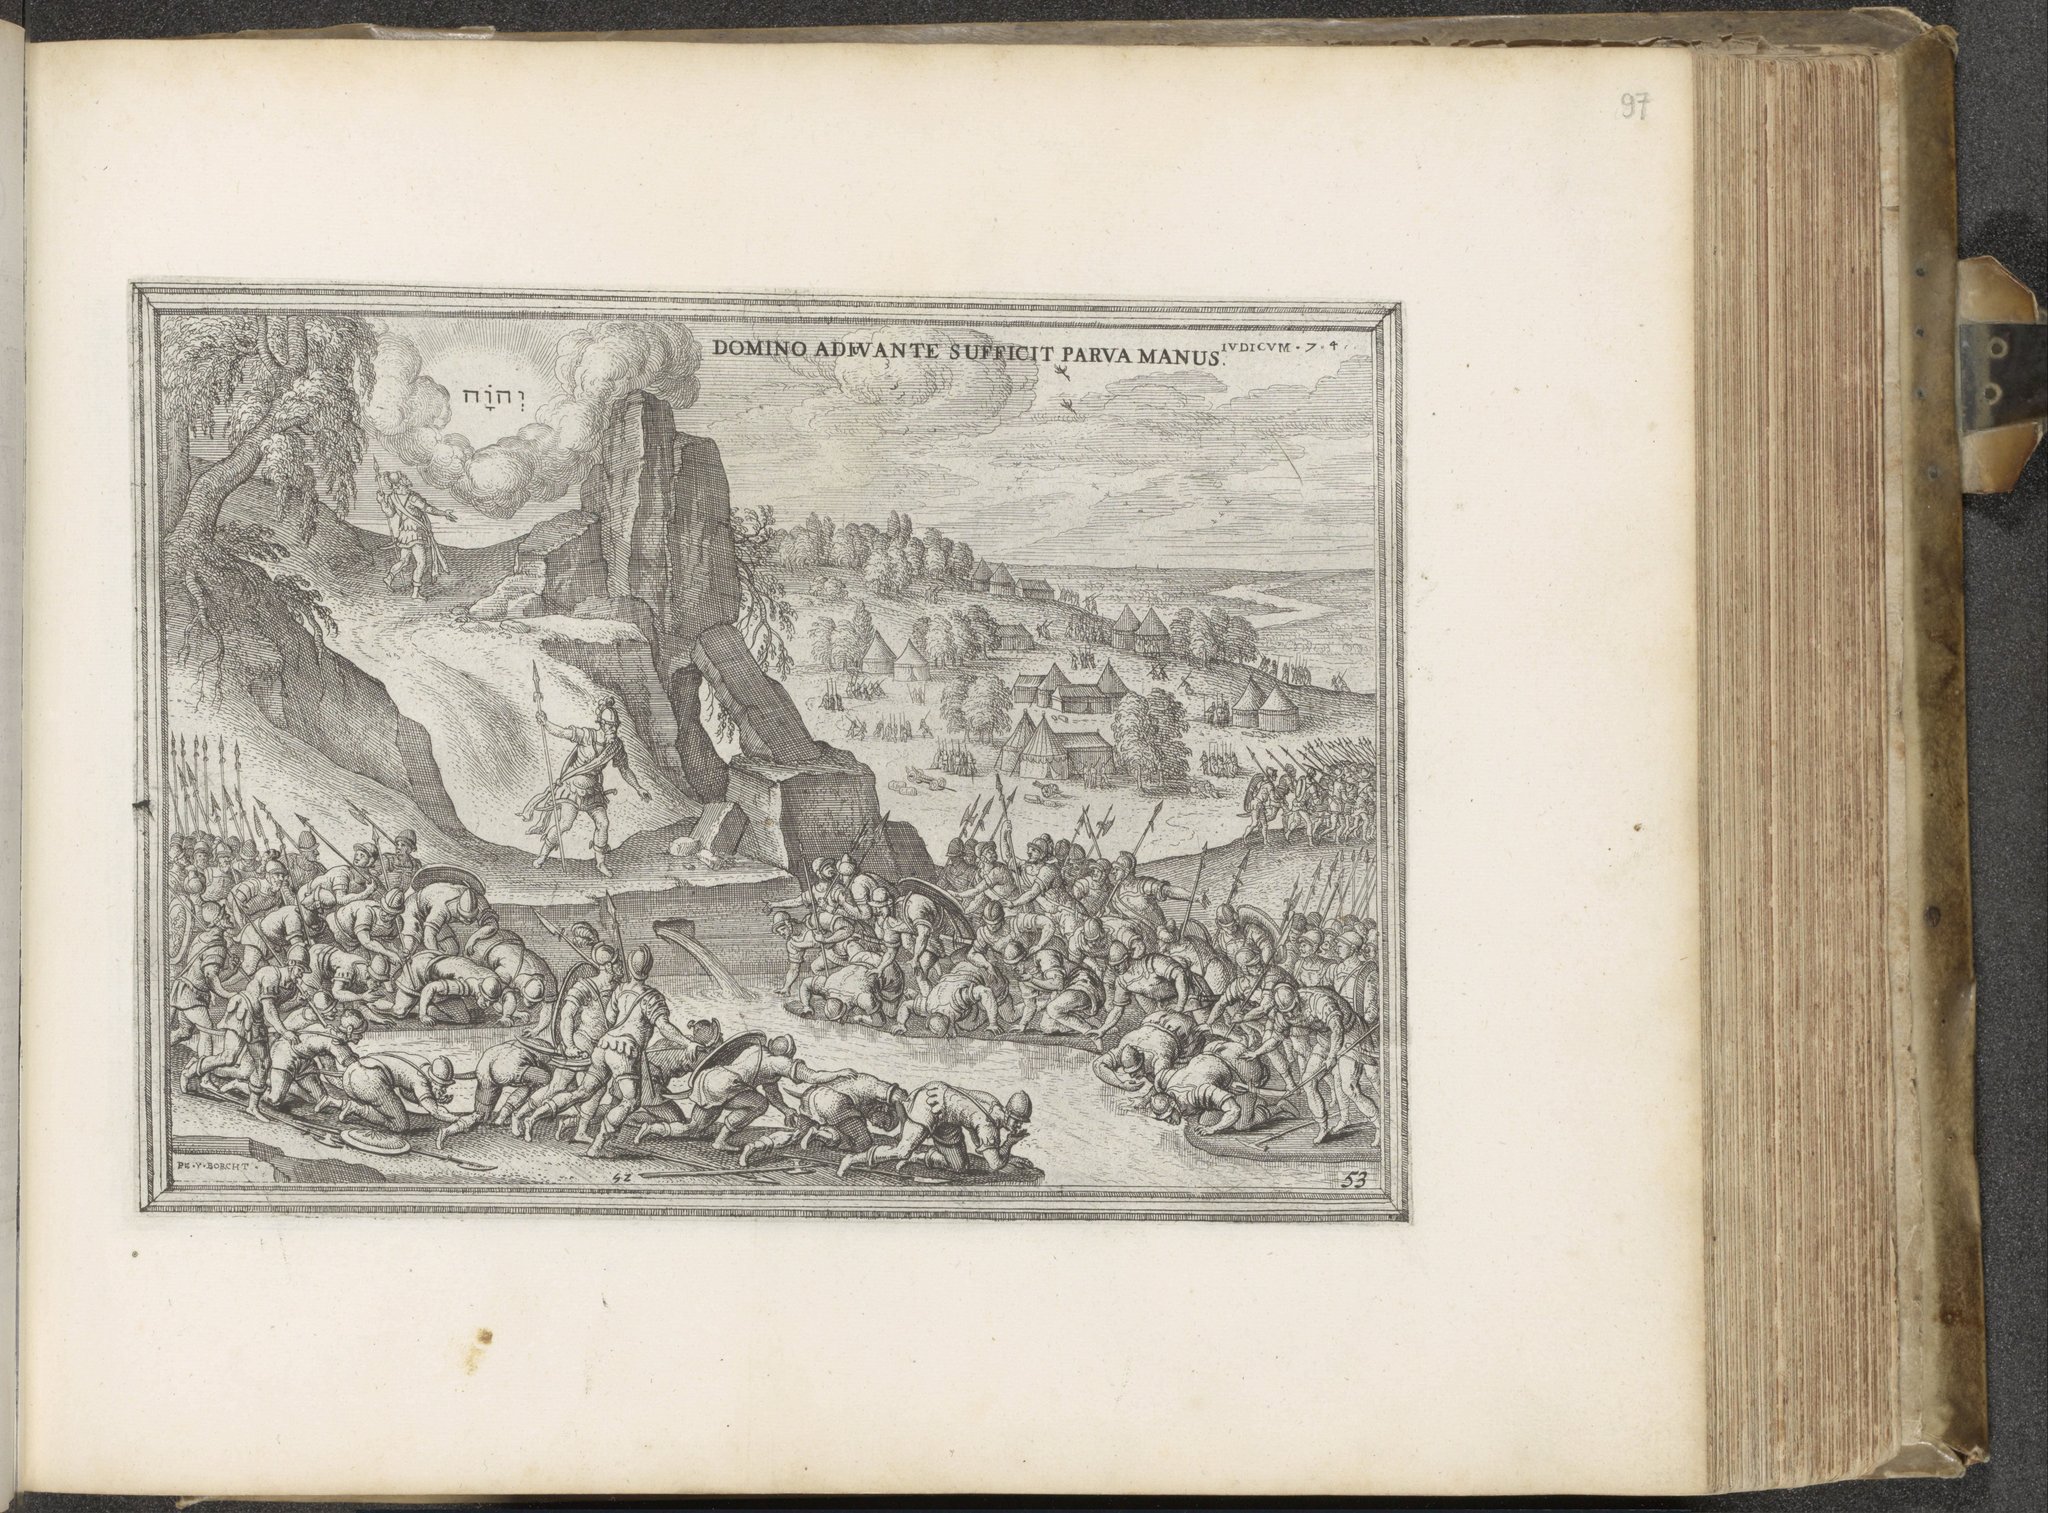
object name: print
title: Domino adjuvante sufficit parva manus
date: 1582-1593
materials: paper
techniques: etching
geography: amsterdam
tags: those who lap water by putting their hand to their mouth are separated from those who kneel down to drink the water ~ selection of gideon's men, tetragram (in roman or hebrew script) ~ symbol of god the father, old testament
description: Links op een berg verschijnt God aan Gideon. Het tetragram staat symbool voor God de Vader. Daaronder beveelt Gideon zijn manschappen water te drinken. Driehonderd man likken het water op met hun tong en de overigen knielen om te drinken. De mannen die knielen om het water te drinken worden naar huis gestuurd (Recht. 7:4). De prent maakt deel uit van een album.